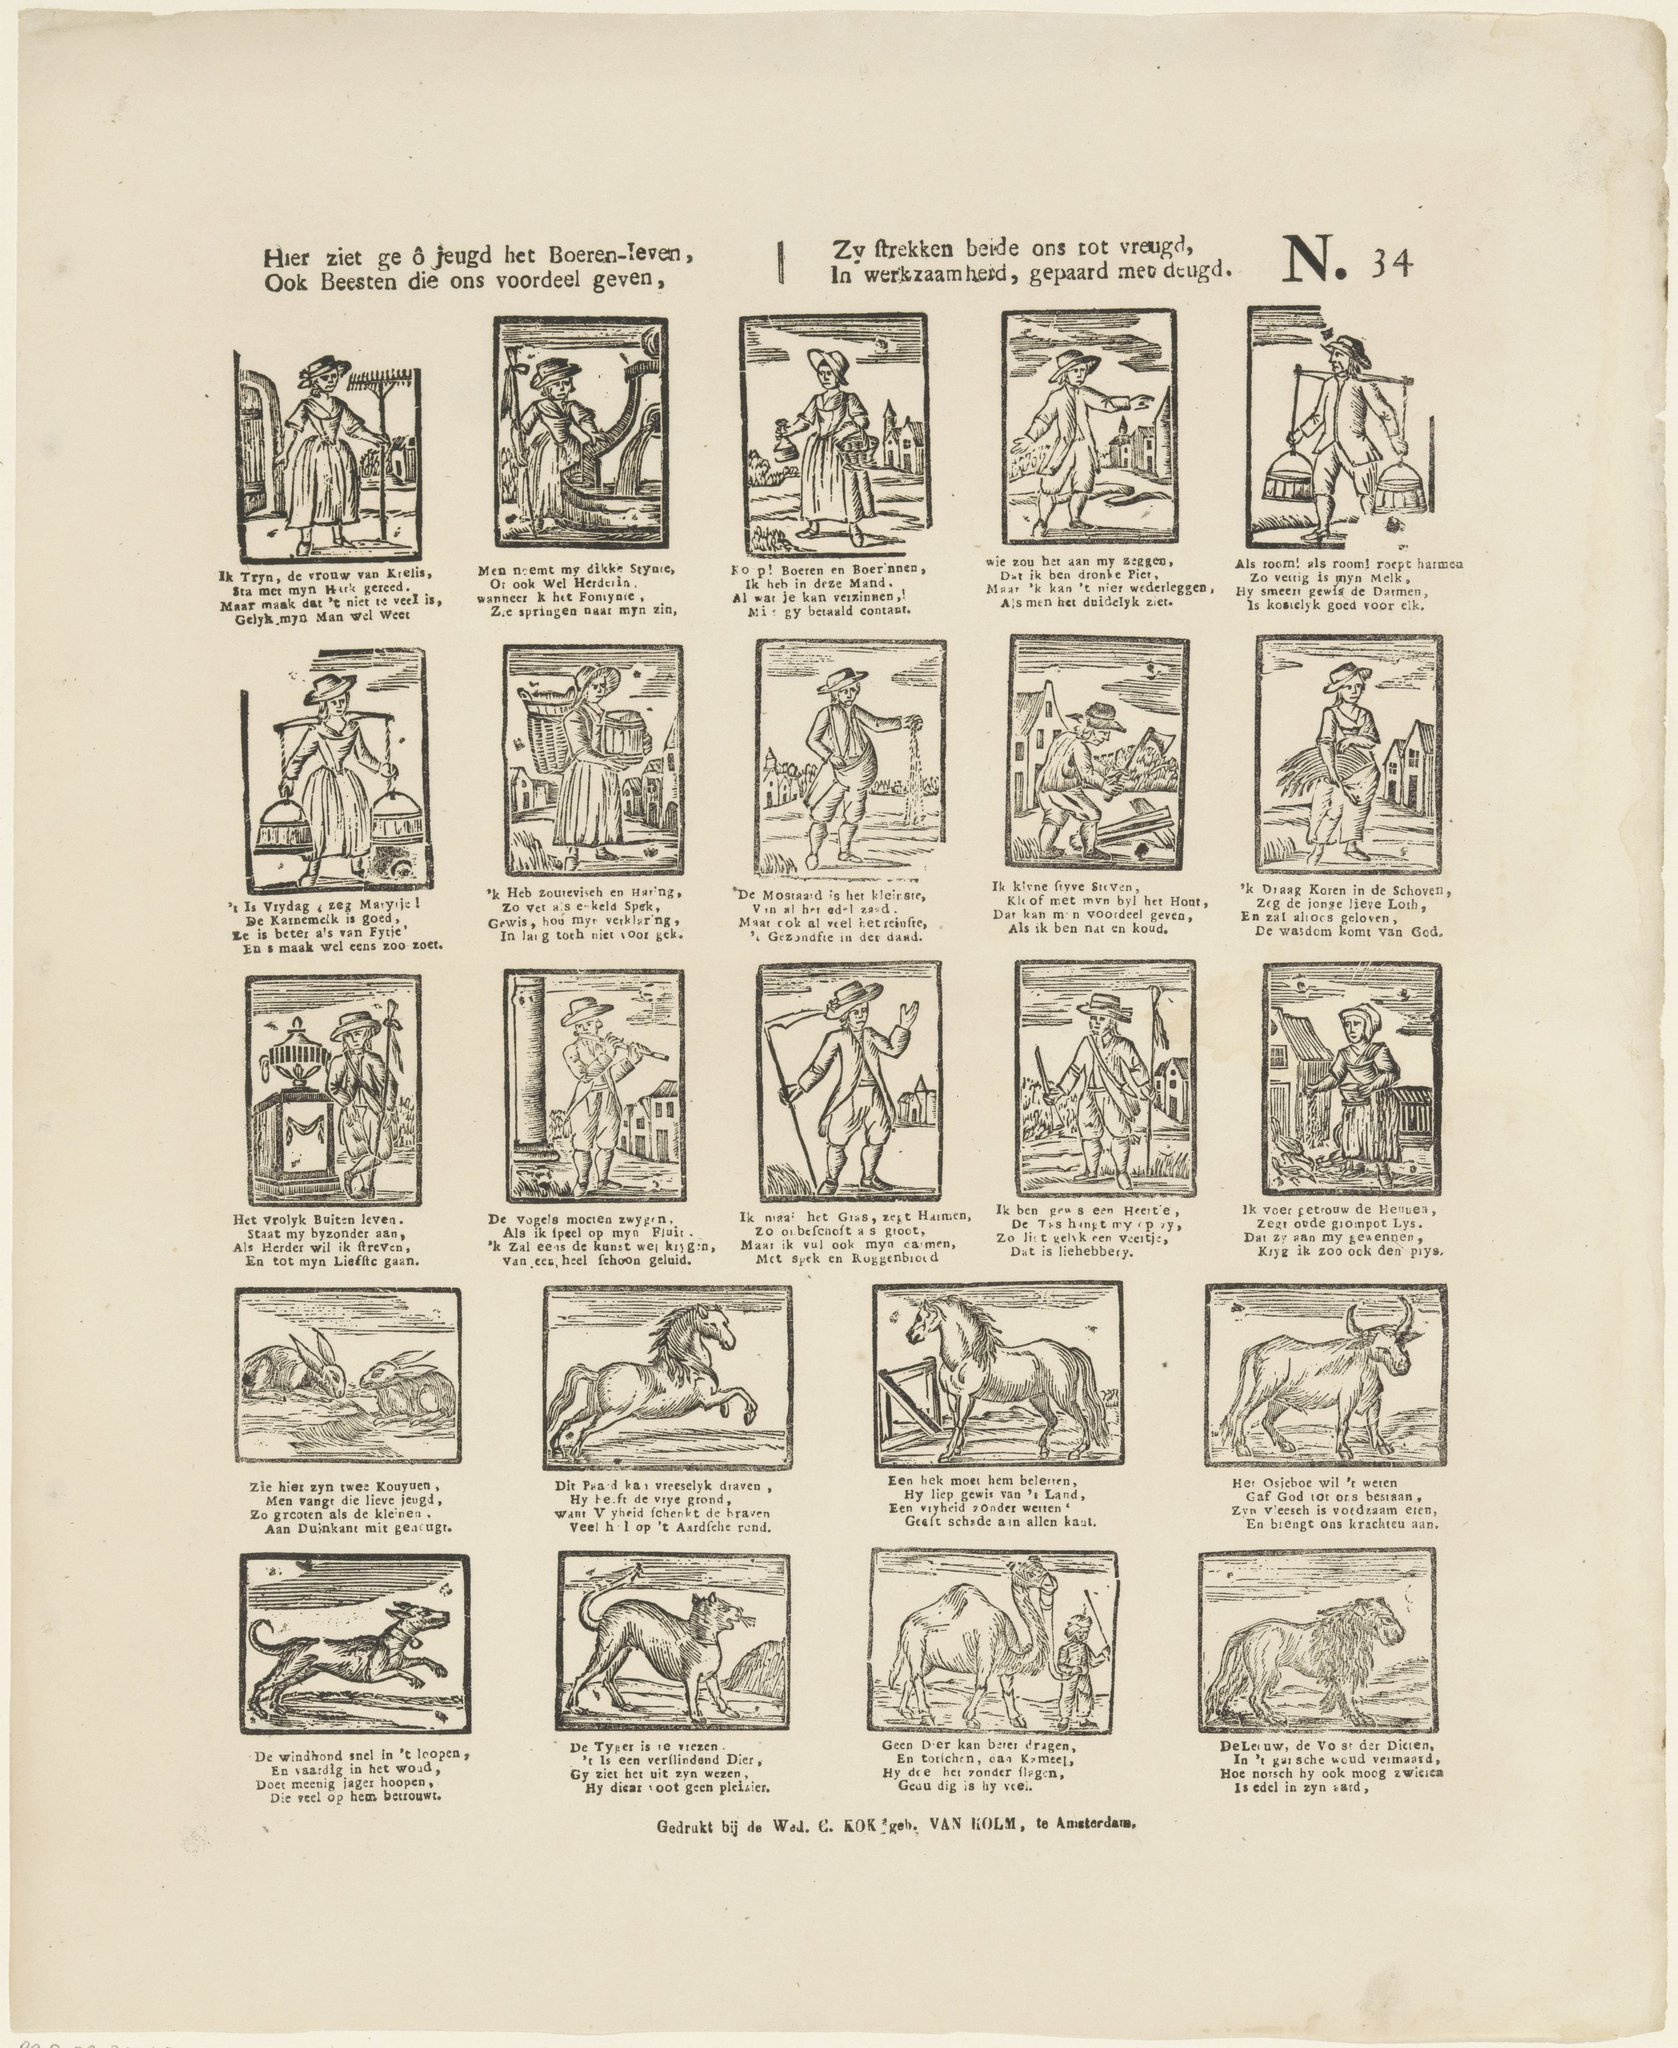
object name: print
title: Hier ziet ge ô jeugd het boeren-leven, / Ook beesten die ons voordeel geven, / Zy strekken beide ons tot vreugd, / In werkzaamheid, gepaard met deugd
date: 1842-1866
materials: paper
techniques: letterpress printing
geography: netherlands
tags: animals, farmers, horse, beasts of prey, predatory animals: lion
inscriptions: collector's mark: Lugt 2760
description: Blad met 25 voorstellingen van verschillende dieren en figuren. Onder elke voorstelling een vierregelig vers. Genummerd rechtsboven: N. 34.